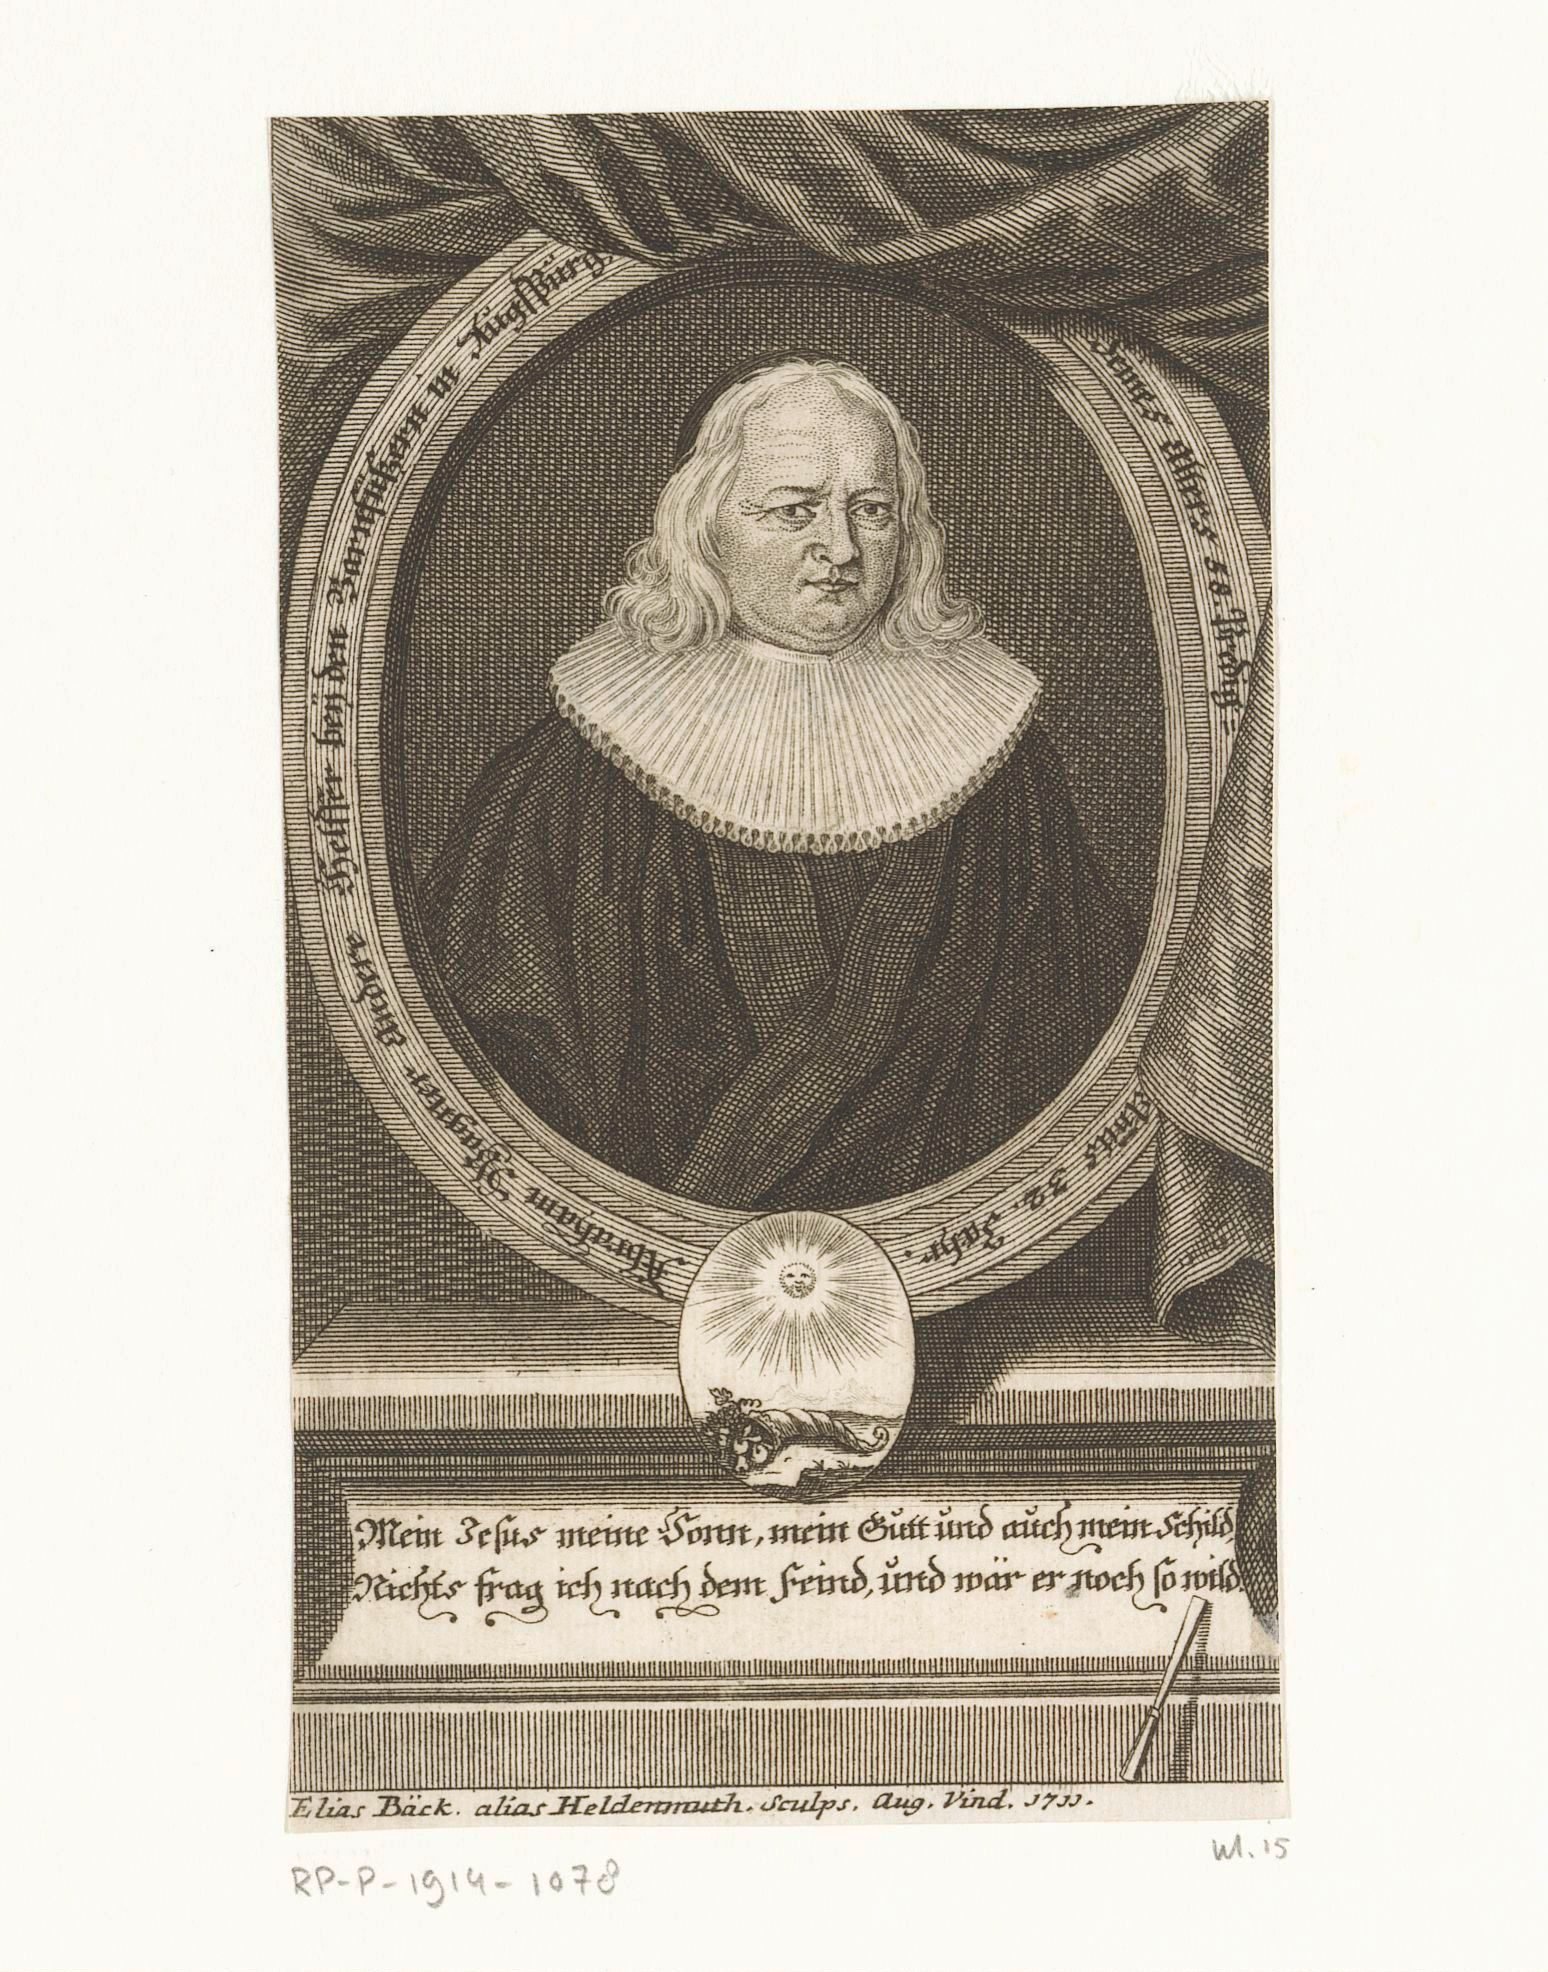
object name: print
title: Portret van Abraham Wagner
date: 1711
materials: paper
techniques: engraving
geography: augsburg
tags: abraham wagner (1653-1728), historical persons, armorial bearing, heraldry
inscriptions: collector's mark: Lugt 2228